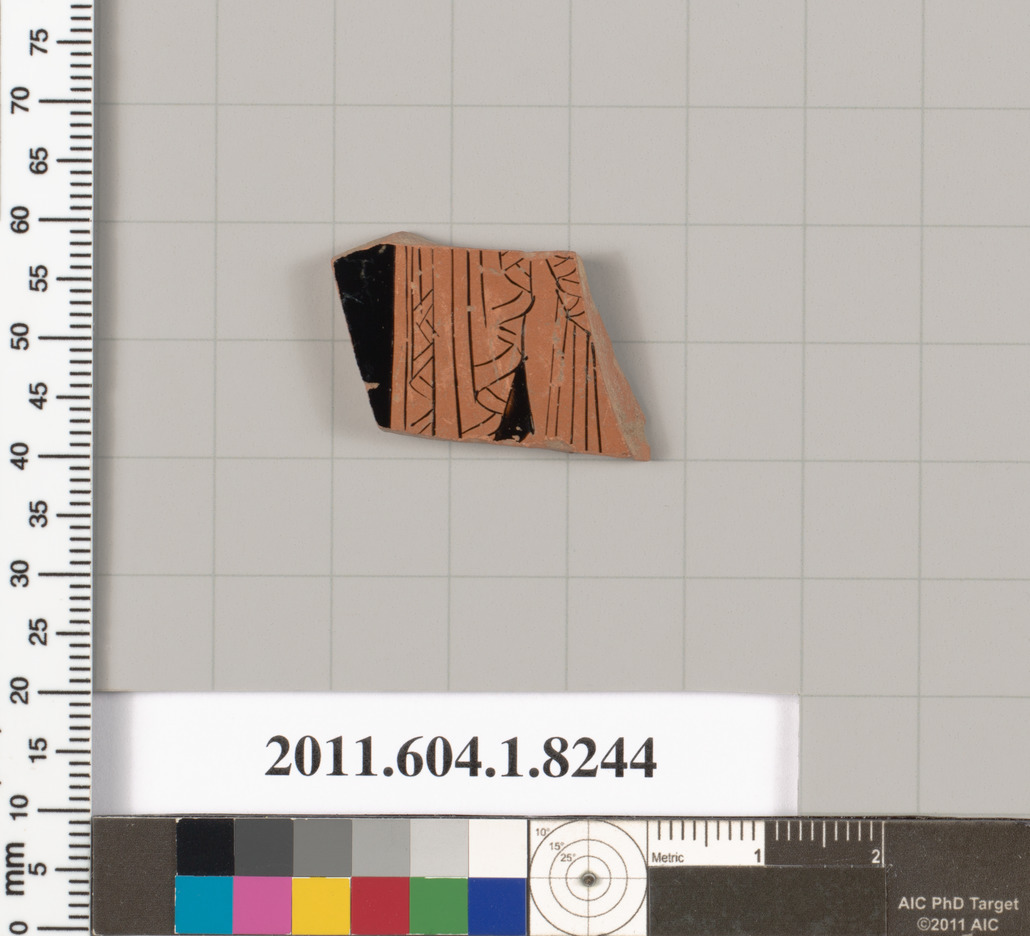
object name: kylix fragment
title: Terracotta fragment of a kylix (drinking cup)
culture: greek, attic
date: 520-510 BCE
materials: terracotta